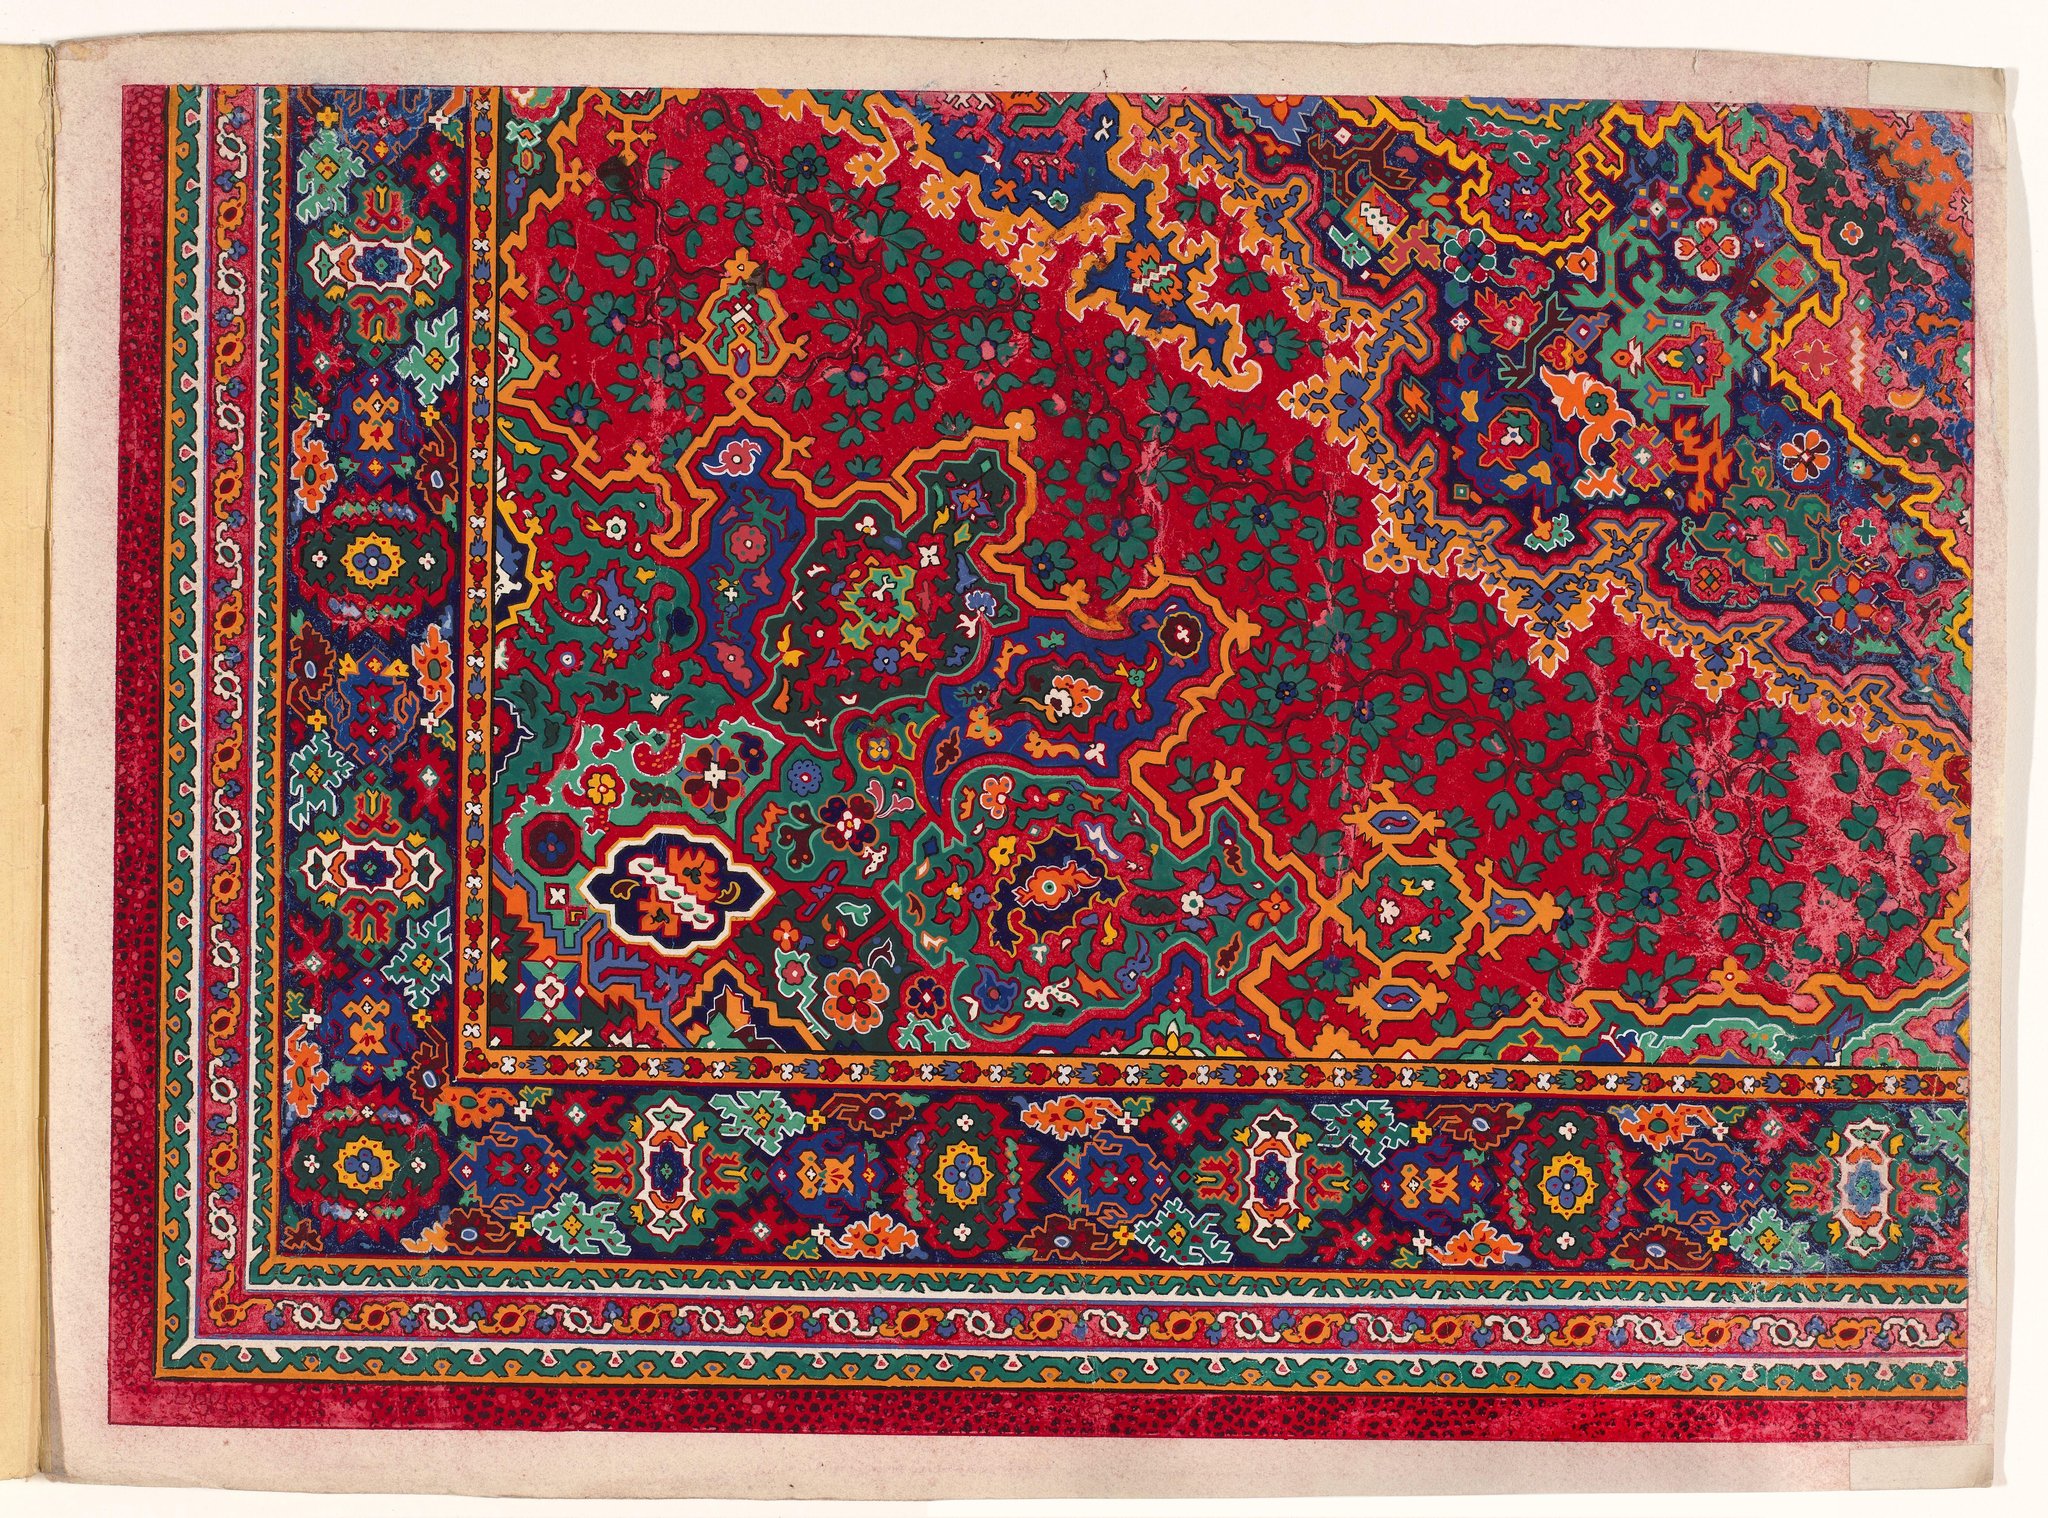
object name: drawing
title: Ontwerp voor een tapijt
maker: Anonymous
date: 1854-1864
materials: gouache, paper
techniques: brush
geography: deventer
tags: ornaments ~ art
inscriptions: inscription: ‘UI’, inscription: ‘J.W. / F.....n’, retailer's mark: ‘JHS.’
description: De presentatietekeningen BK-1971-77-1 t/m 86 zijn kopieën van de originele ontwerptekeningen. Ze werden gemaakt voor vertegenwoordigers van bijvoorbeeld magazijnen, die ze aan hun klanten konden tonen. De meeste tekeningen tonen een kwart van het dessin inclusief rand, middenpartij (de zogenaamde grond of fond) en centraal medaillon. Door het gebruik van spiegels kan de illusie van het gehele tapijt worden opgeroepen. Een deel van de tekeningen heeft een alfabetische opeenvolgende letter als kenmerk, de andere groep een cijfer.Waarschijnlijk is de reeks dessins met een letter eerder samengesteld dan de genummerde tekeningen.